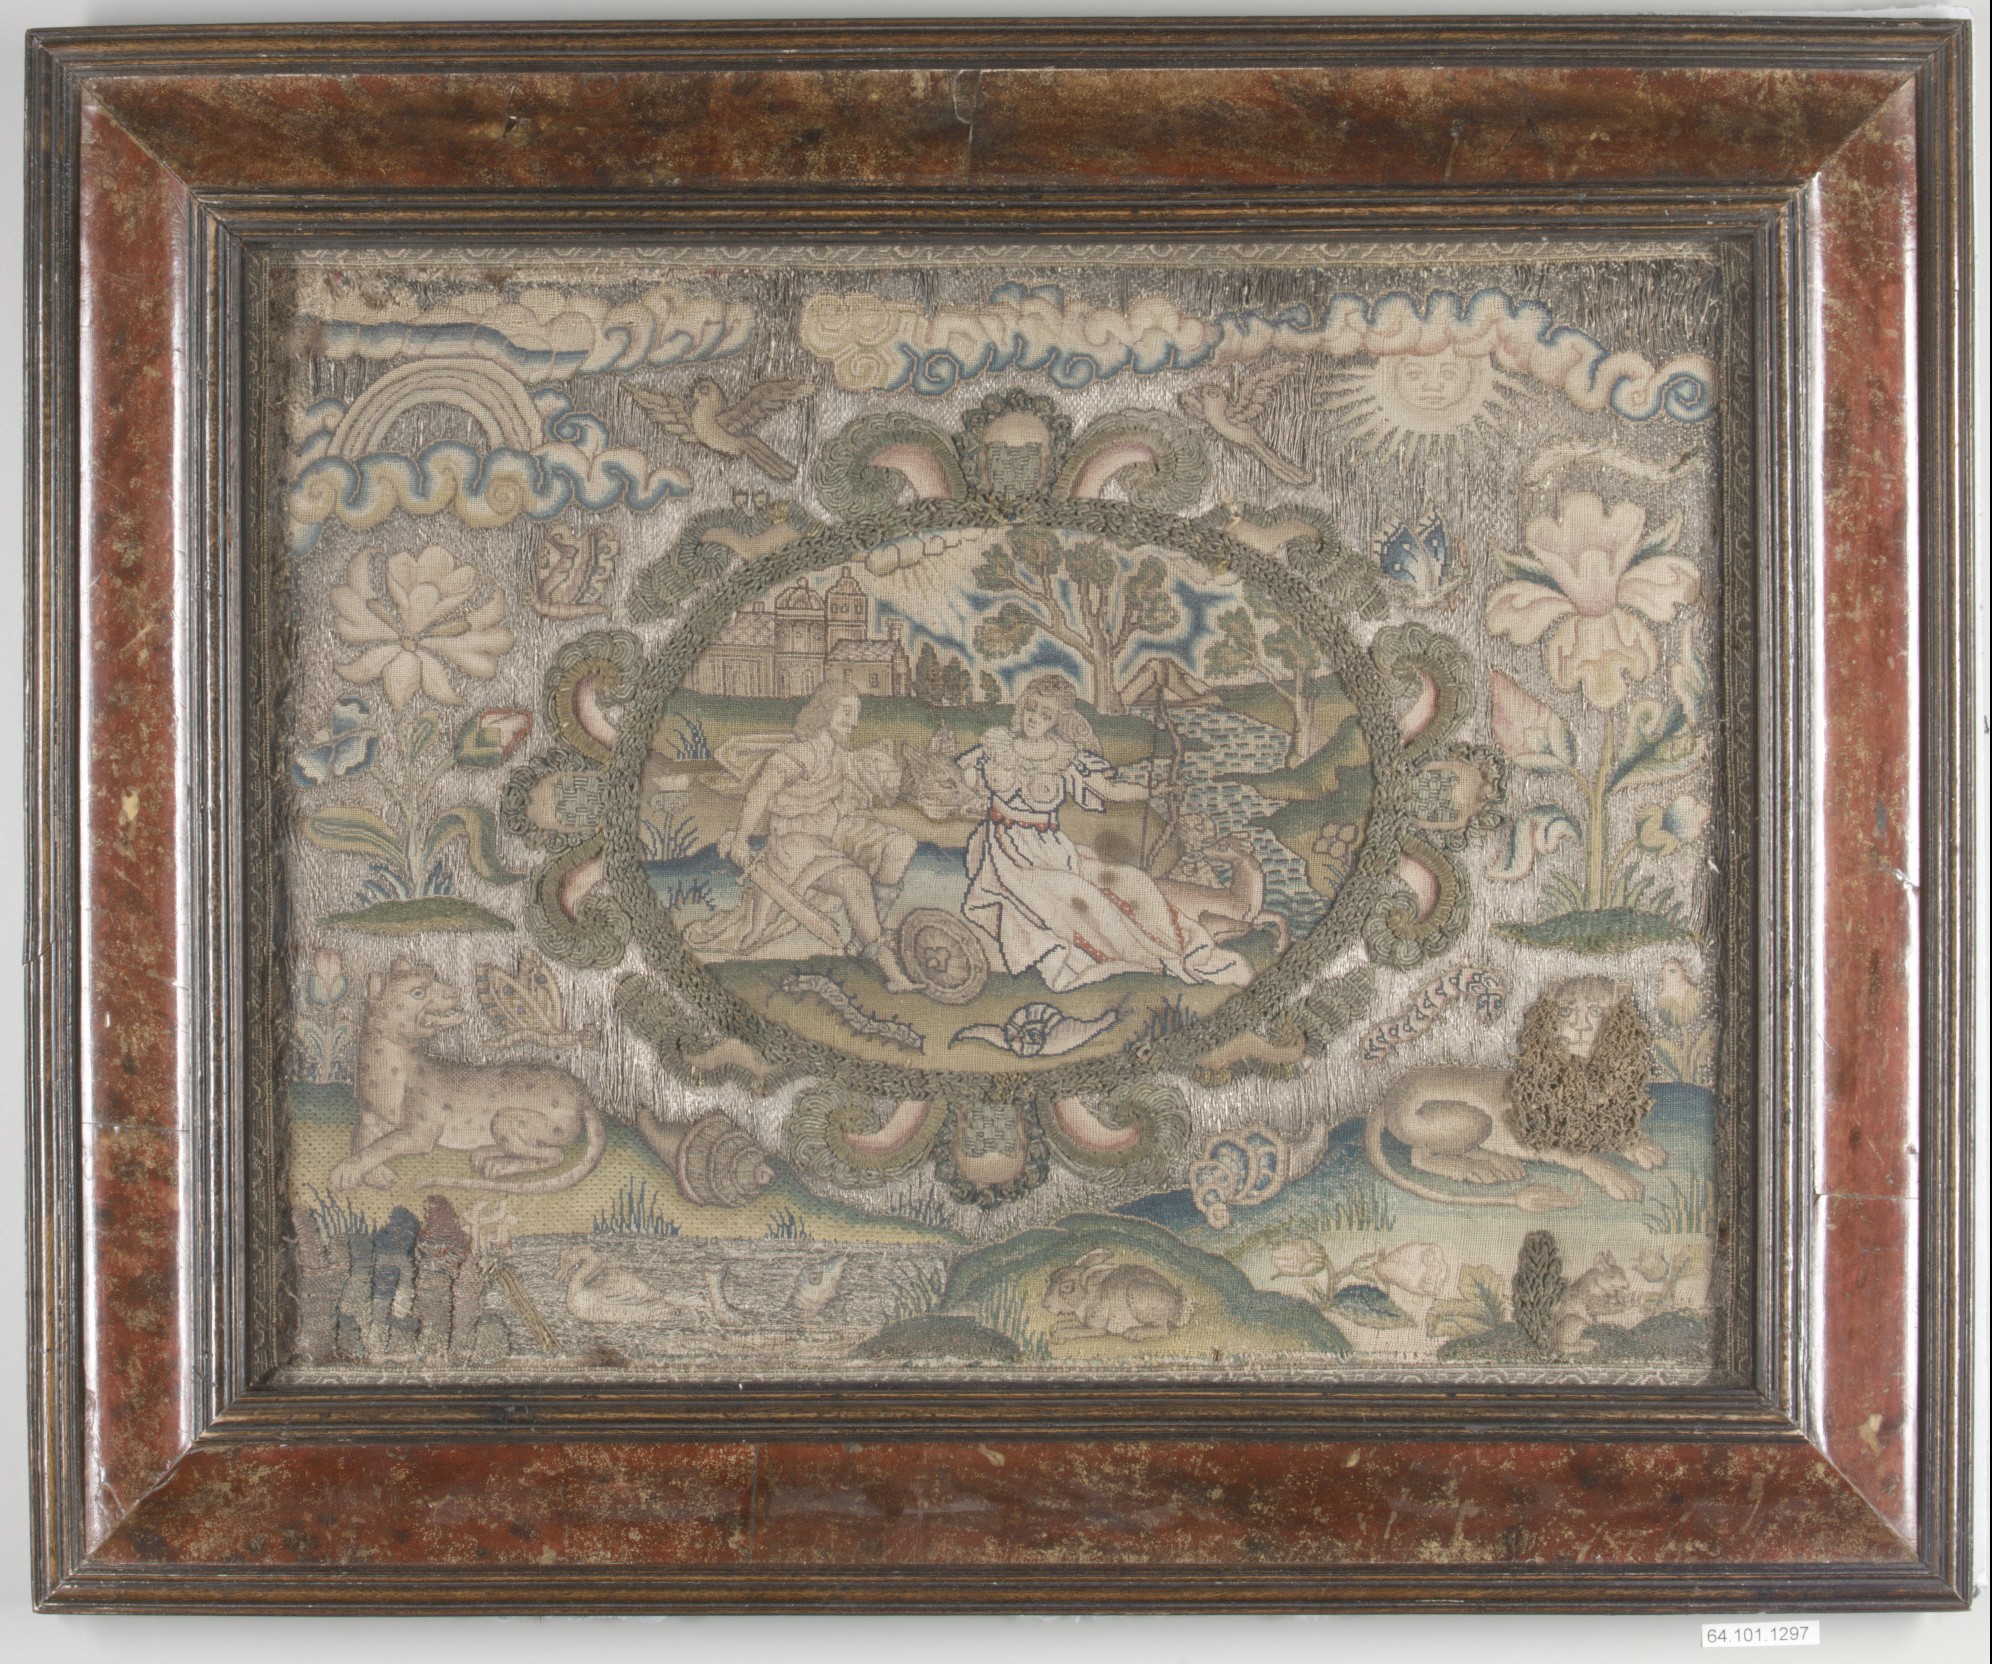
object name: embroidered picture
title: Meleager and Atalanta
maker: crispijn de passe the younger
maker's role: artist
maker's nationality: dutch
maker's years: 1590-1670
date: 1601-1625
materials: canvas, metal thread, silk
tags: birds,men,women,lions,rabbits,tigers,sun